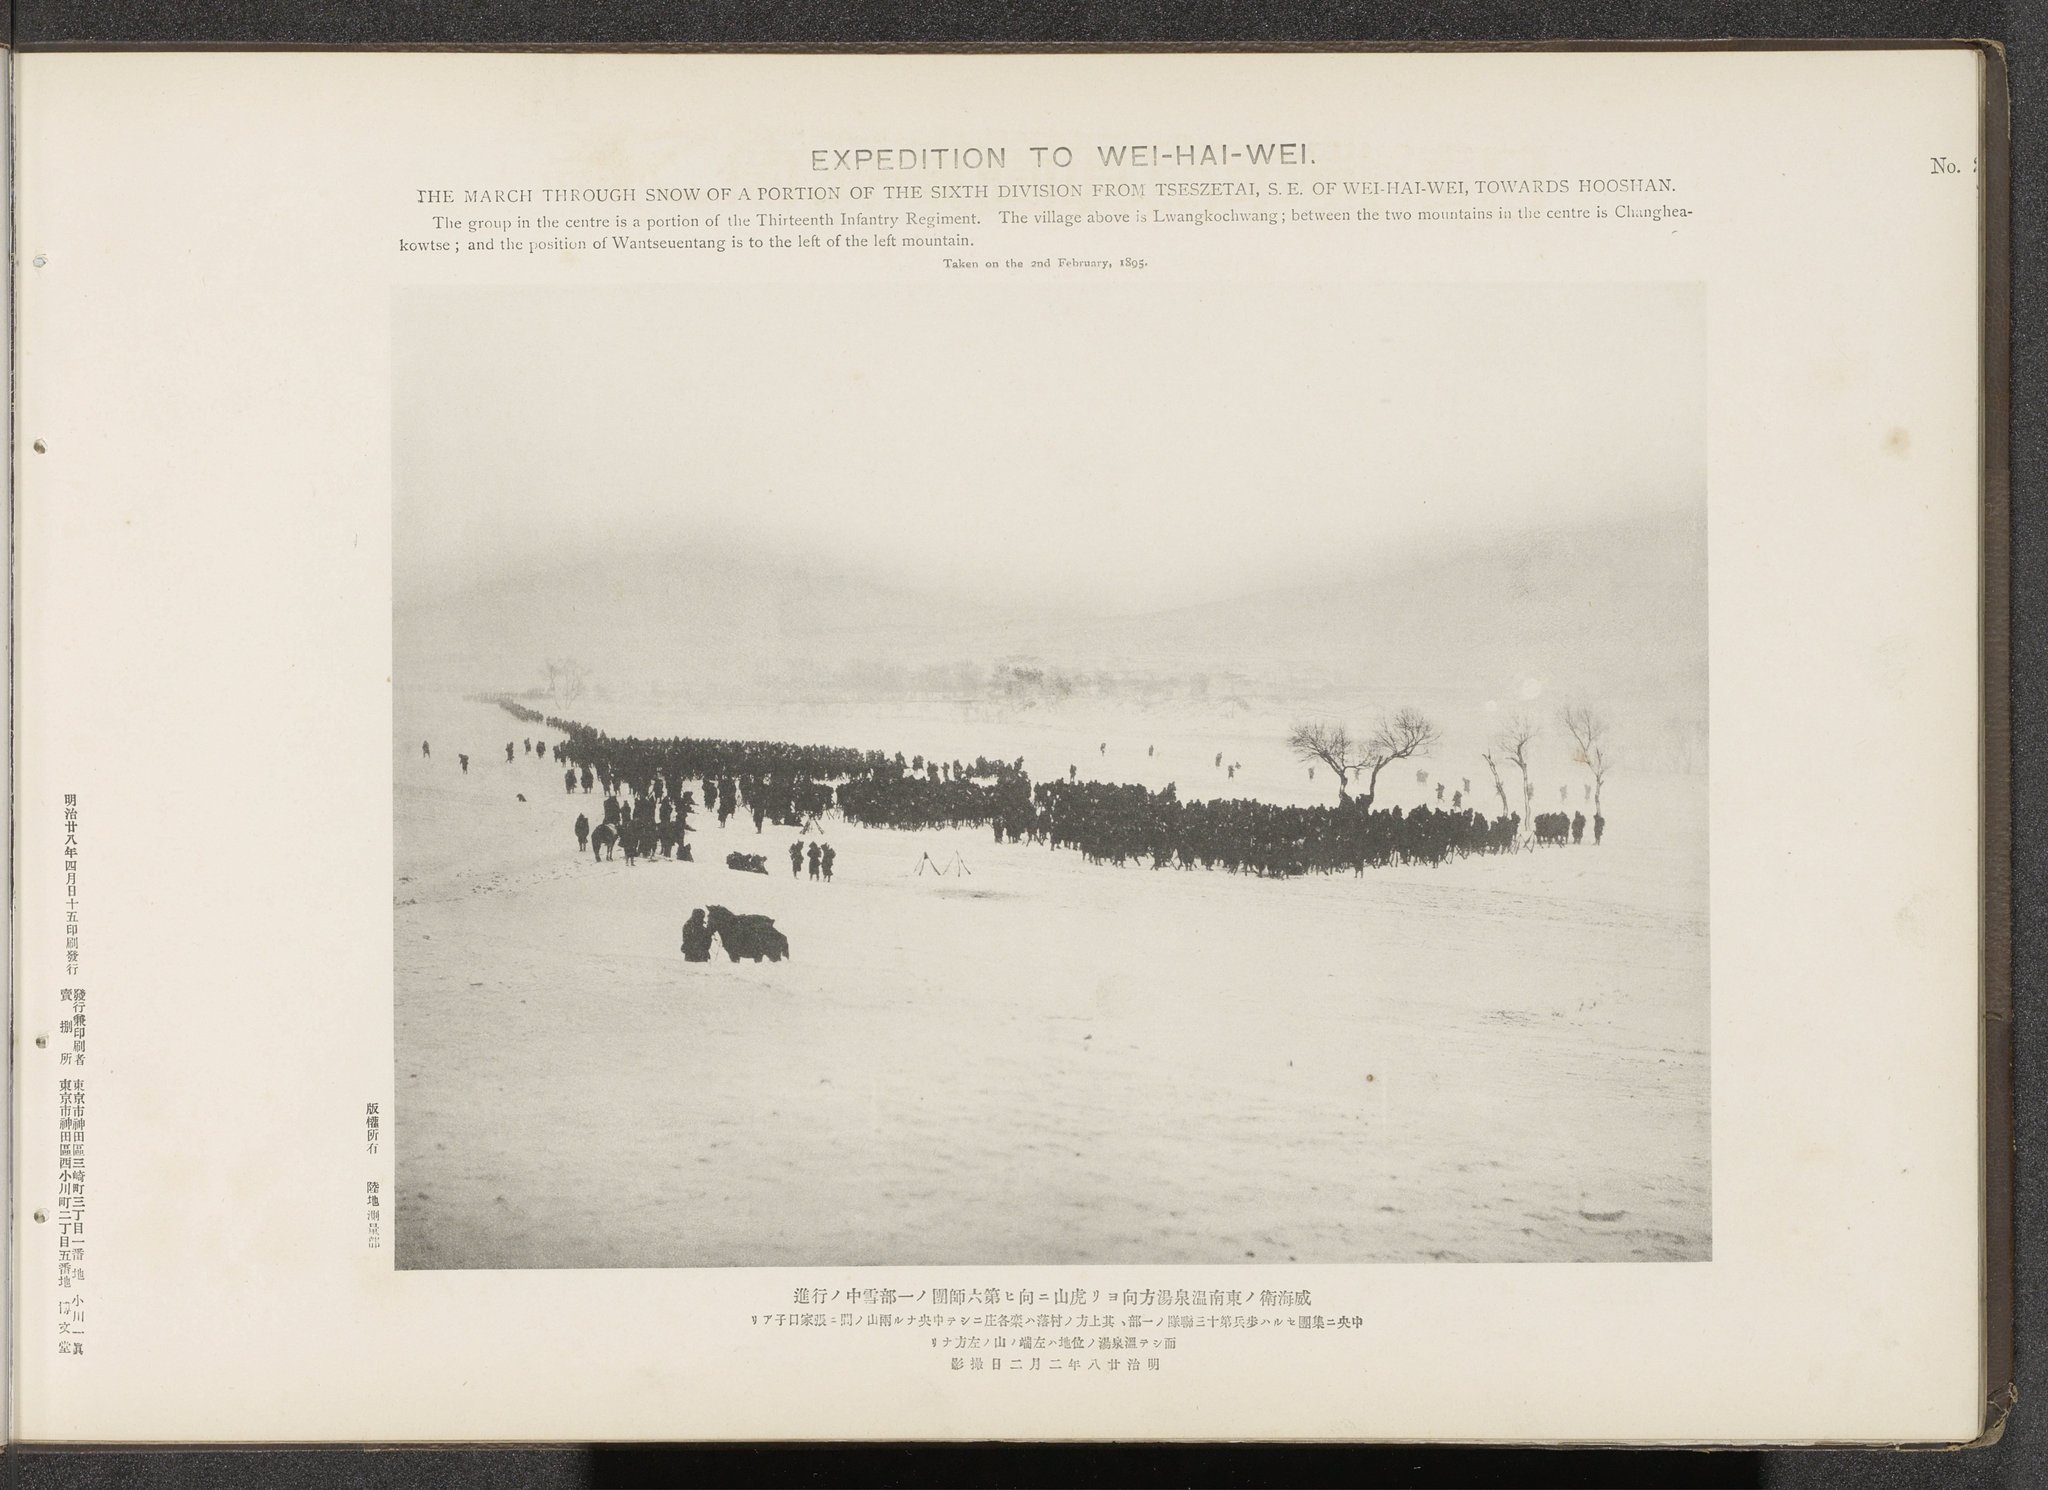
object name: photomechanical print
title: The march through snow of a portion of the sixth division from Tseszetai, S.E. of Wei-hai-Wei, towards Hooshan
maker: kazumasa ogawa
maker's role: auteur, fotograaf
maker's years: 1860-1929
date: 1895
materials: paper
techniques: photograph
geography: japan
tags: marching away (troops), snow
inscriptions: inscription: ‘Expedition to Wei-Hai-Wei.’, inscription: ‘The group in the centre (...) to the left of the left mountain.’